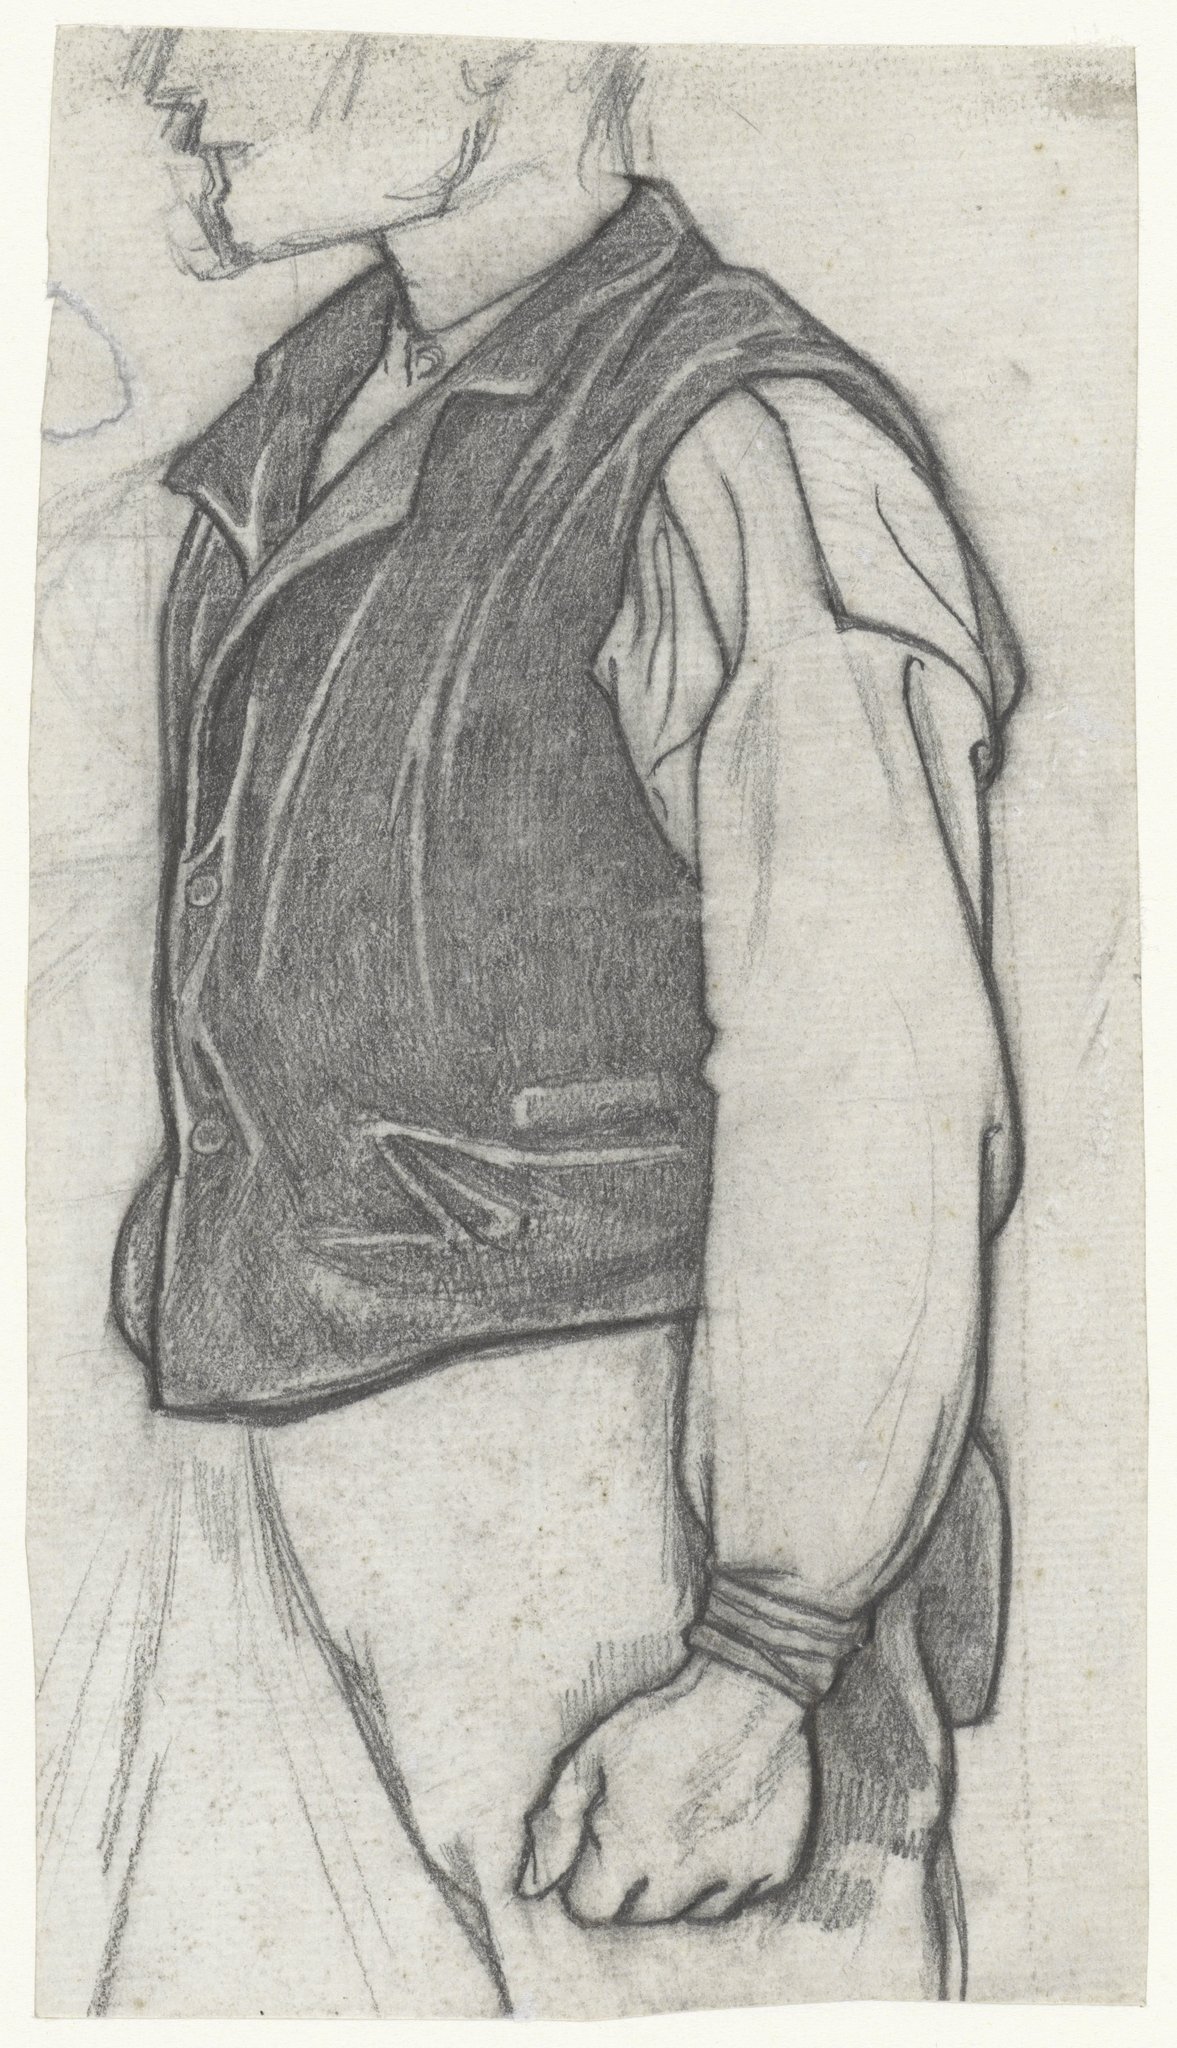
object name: drawing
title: Bovenlichaam van een man met gebalde vuist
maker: richard nicolaüs roland holst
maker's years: 1868-1938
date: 1878-1938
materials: chalk, paper, pencil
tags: clothing for the upper part of the body (vest) (+ men's clothes), clothes, costume (+ men's clothes)